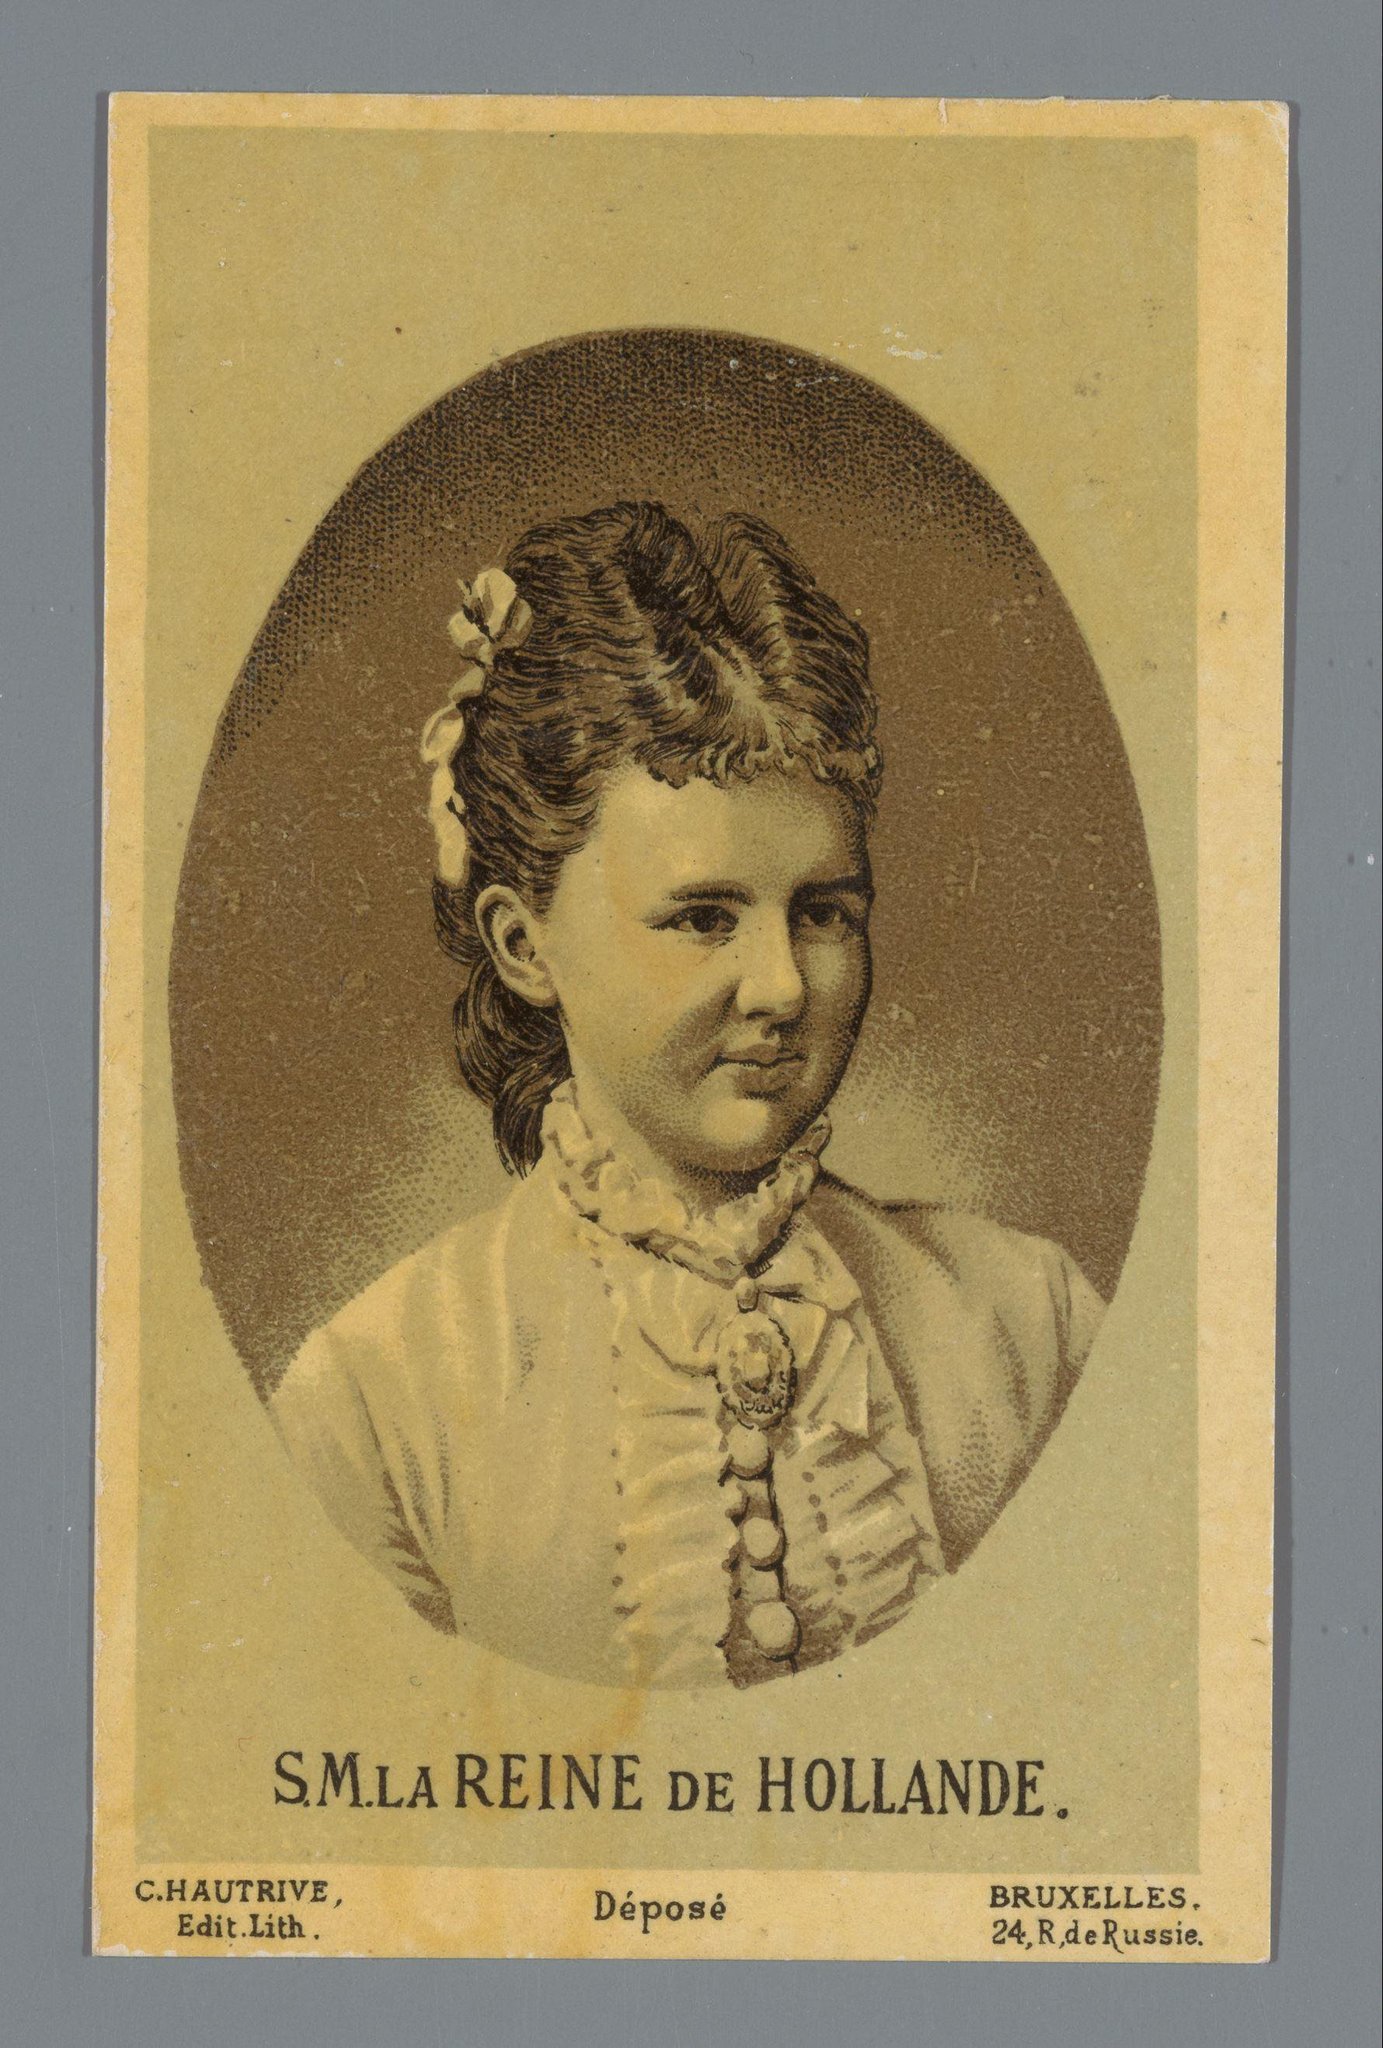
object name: photomechanical print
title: Portret van koningin Emma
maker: c. hautrive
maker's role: printer, publisher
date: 1879-1890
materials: cardboard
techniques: photolithography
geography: brussels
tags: emma (queen consort of the netherlands), historical persons, princess